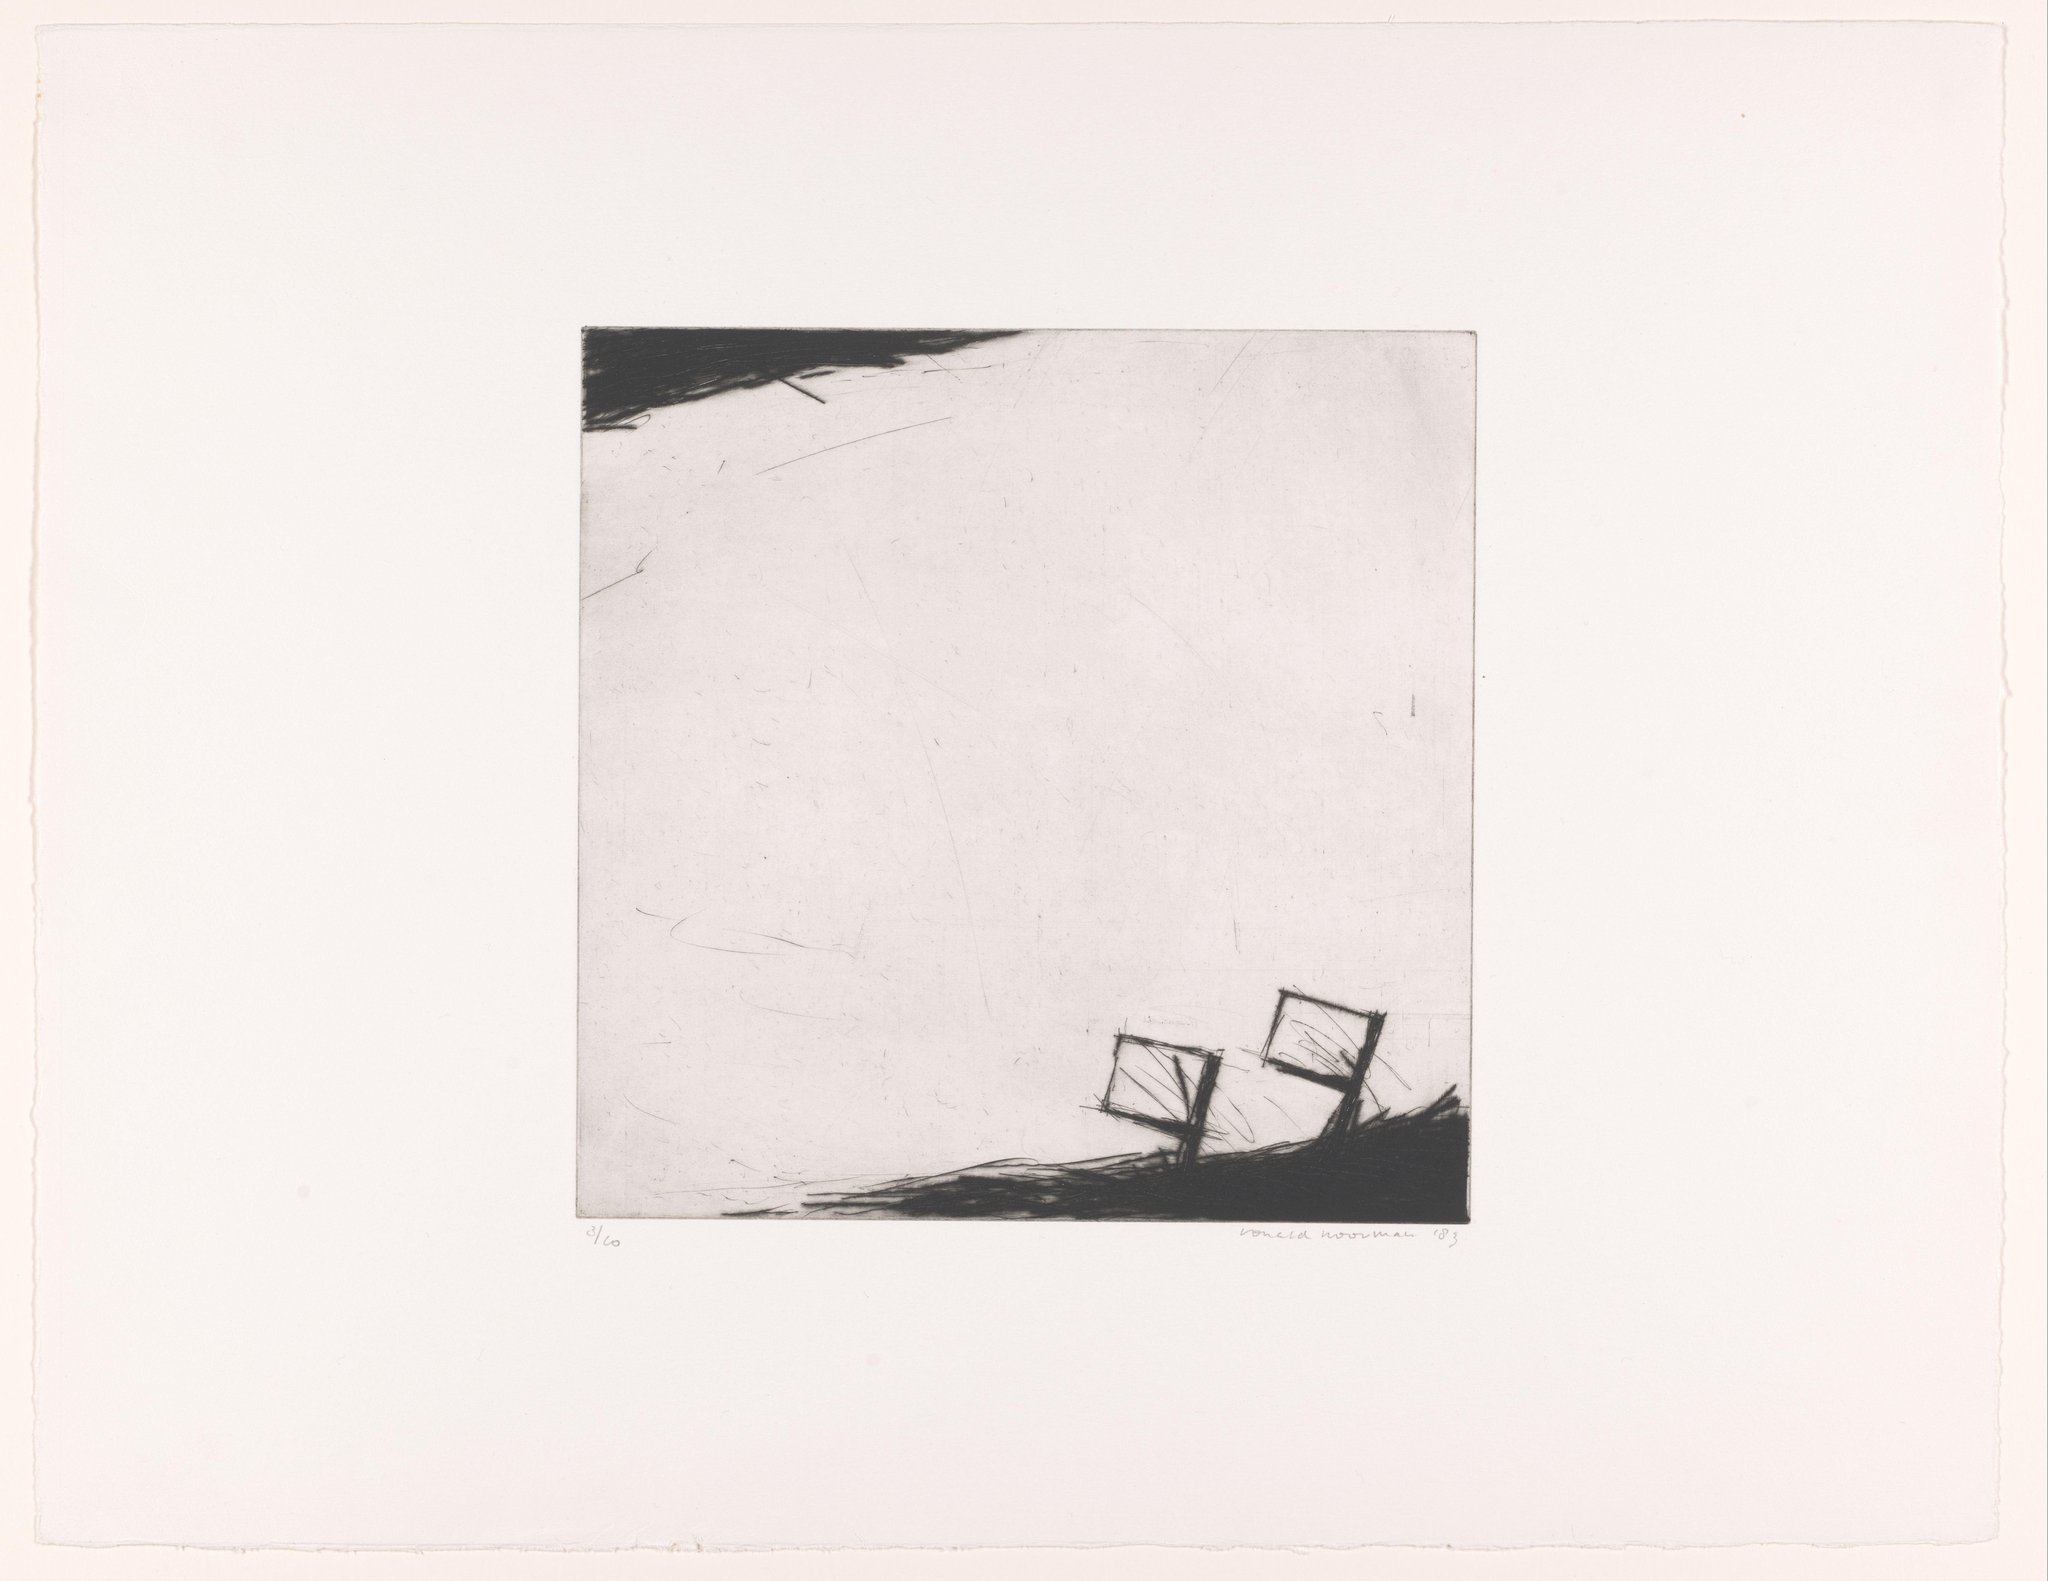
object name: print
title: Vlaggetjes van stijve stukken plastic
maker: ronald noorman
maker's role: draughtsman, print maker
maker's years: 1951-2018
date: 1983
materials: paper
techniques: drypoint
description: Vlaggetjes gemaakt van stijve stukken plastic (kunstmestzakken), die voor de boeren als indicatiepunten dienen om op het juiste moment de machines af te wenden.